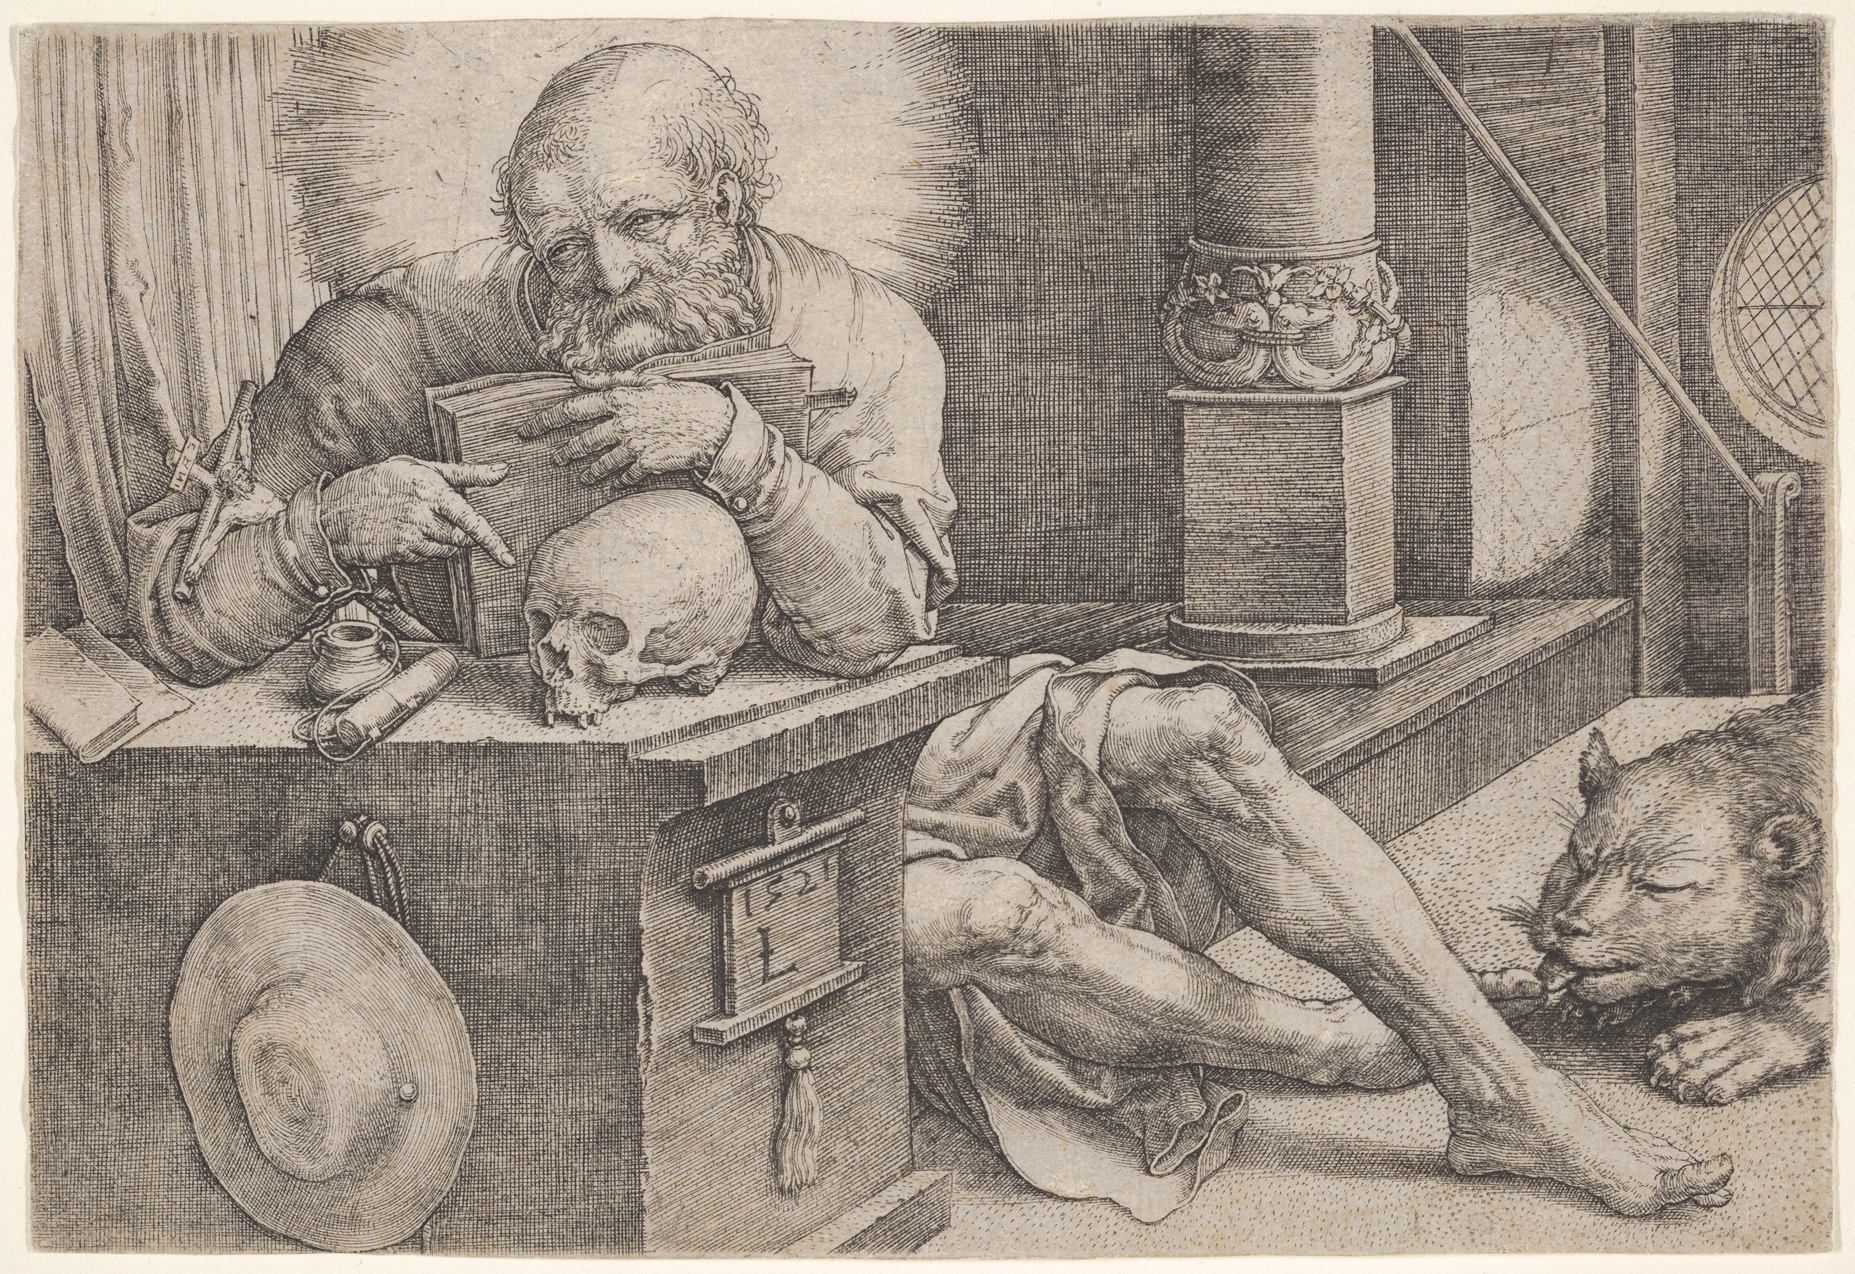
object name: print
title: St. Jerome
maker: lucas van leyden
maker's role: artist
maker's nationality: netherlandish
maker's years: 1494-1533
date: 1521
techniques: engraving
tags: animals,skulls,saint jerome